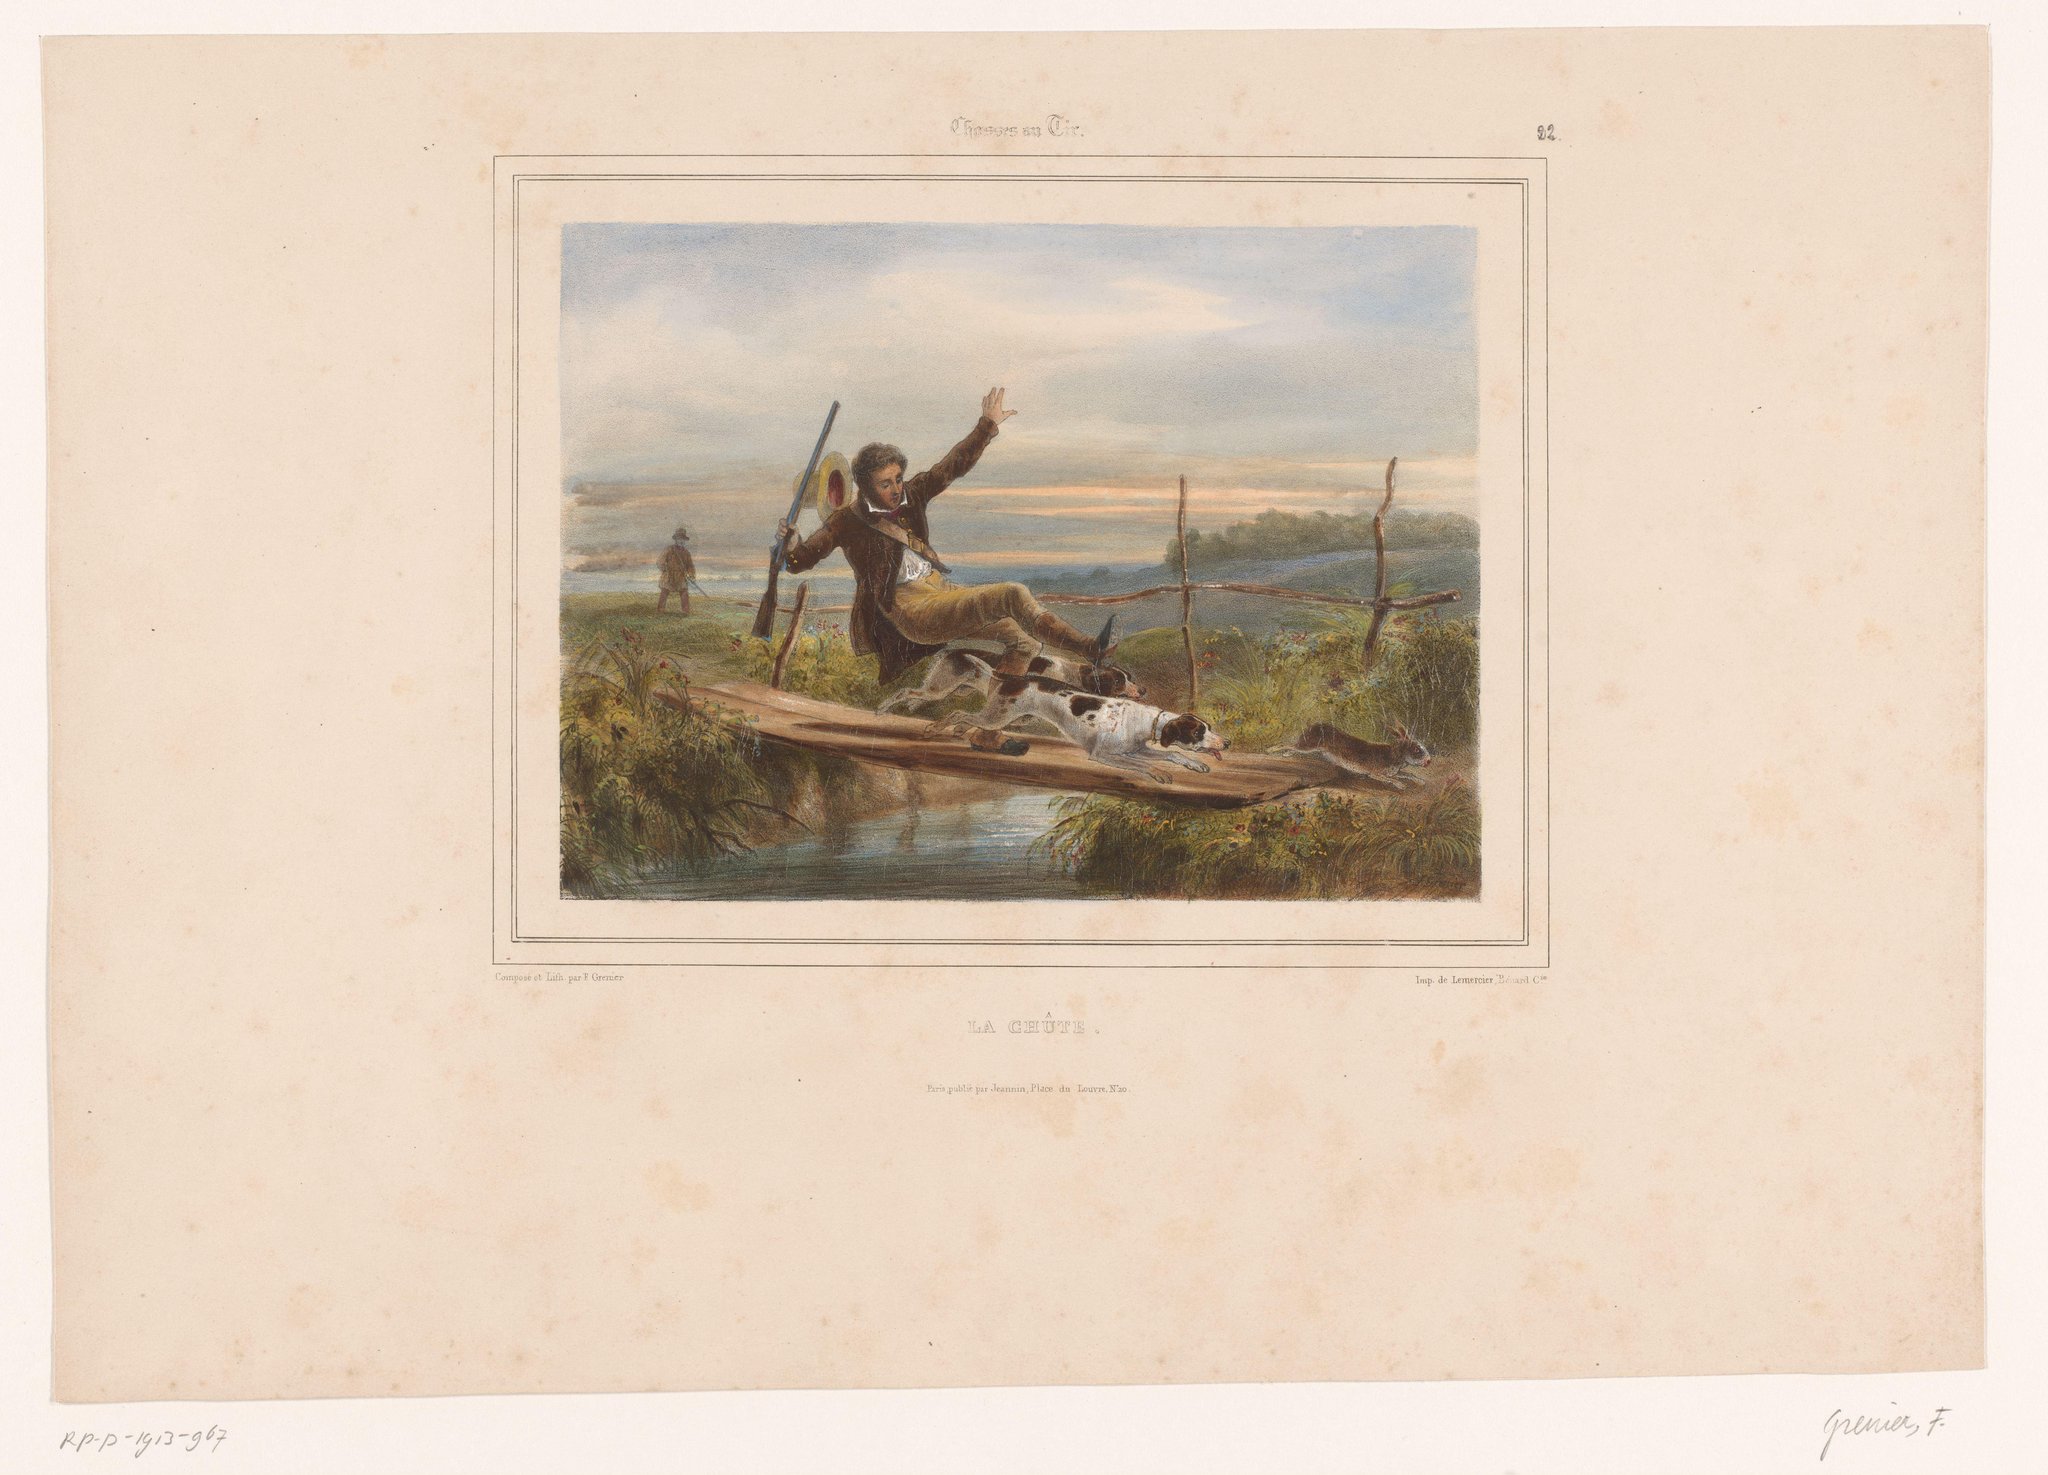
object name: print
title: La chûte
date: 1831-1846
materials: paper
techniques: hand coloring, lithograph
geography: paris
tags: hunter, hare-hunting, rabbit-hunting, firearms: rifle, falling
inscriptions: collector's mark: Lugt 2228a, check stamp: Lugt 1397c